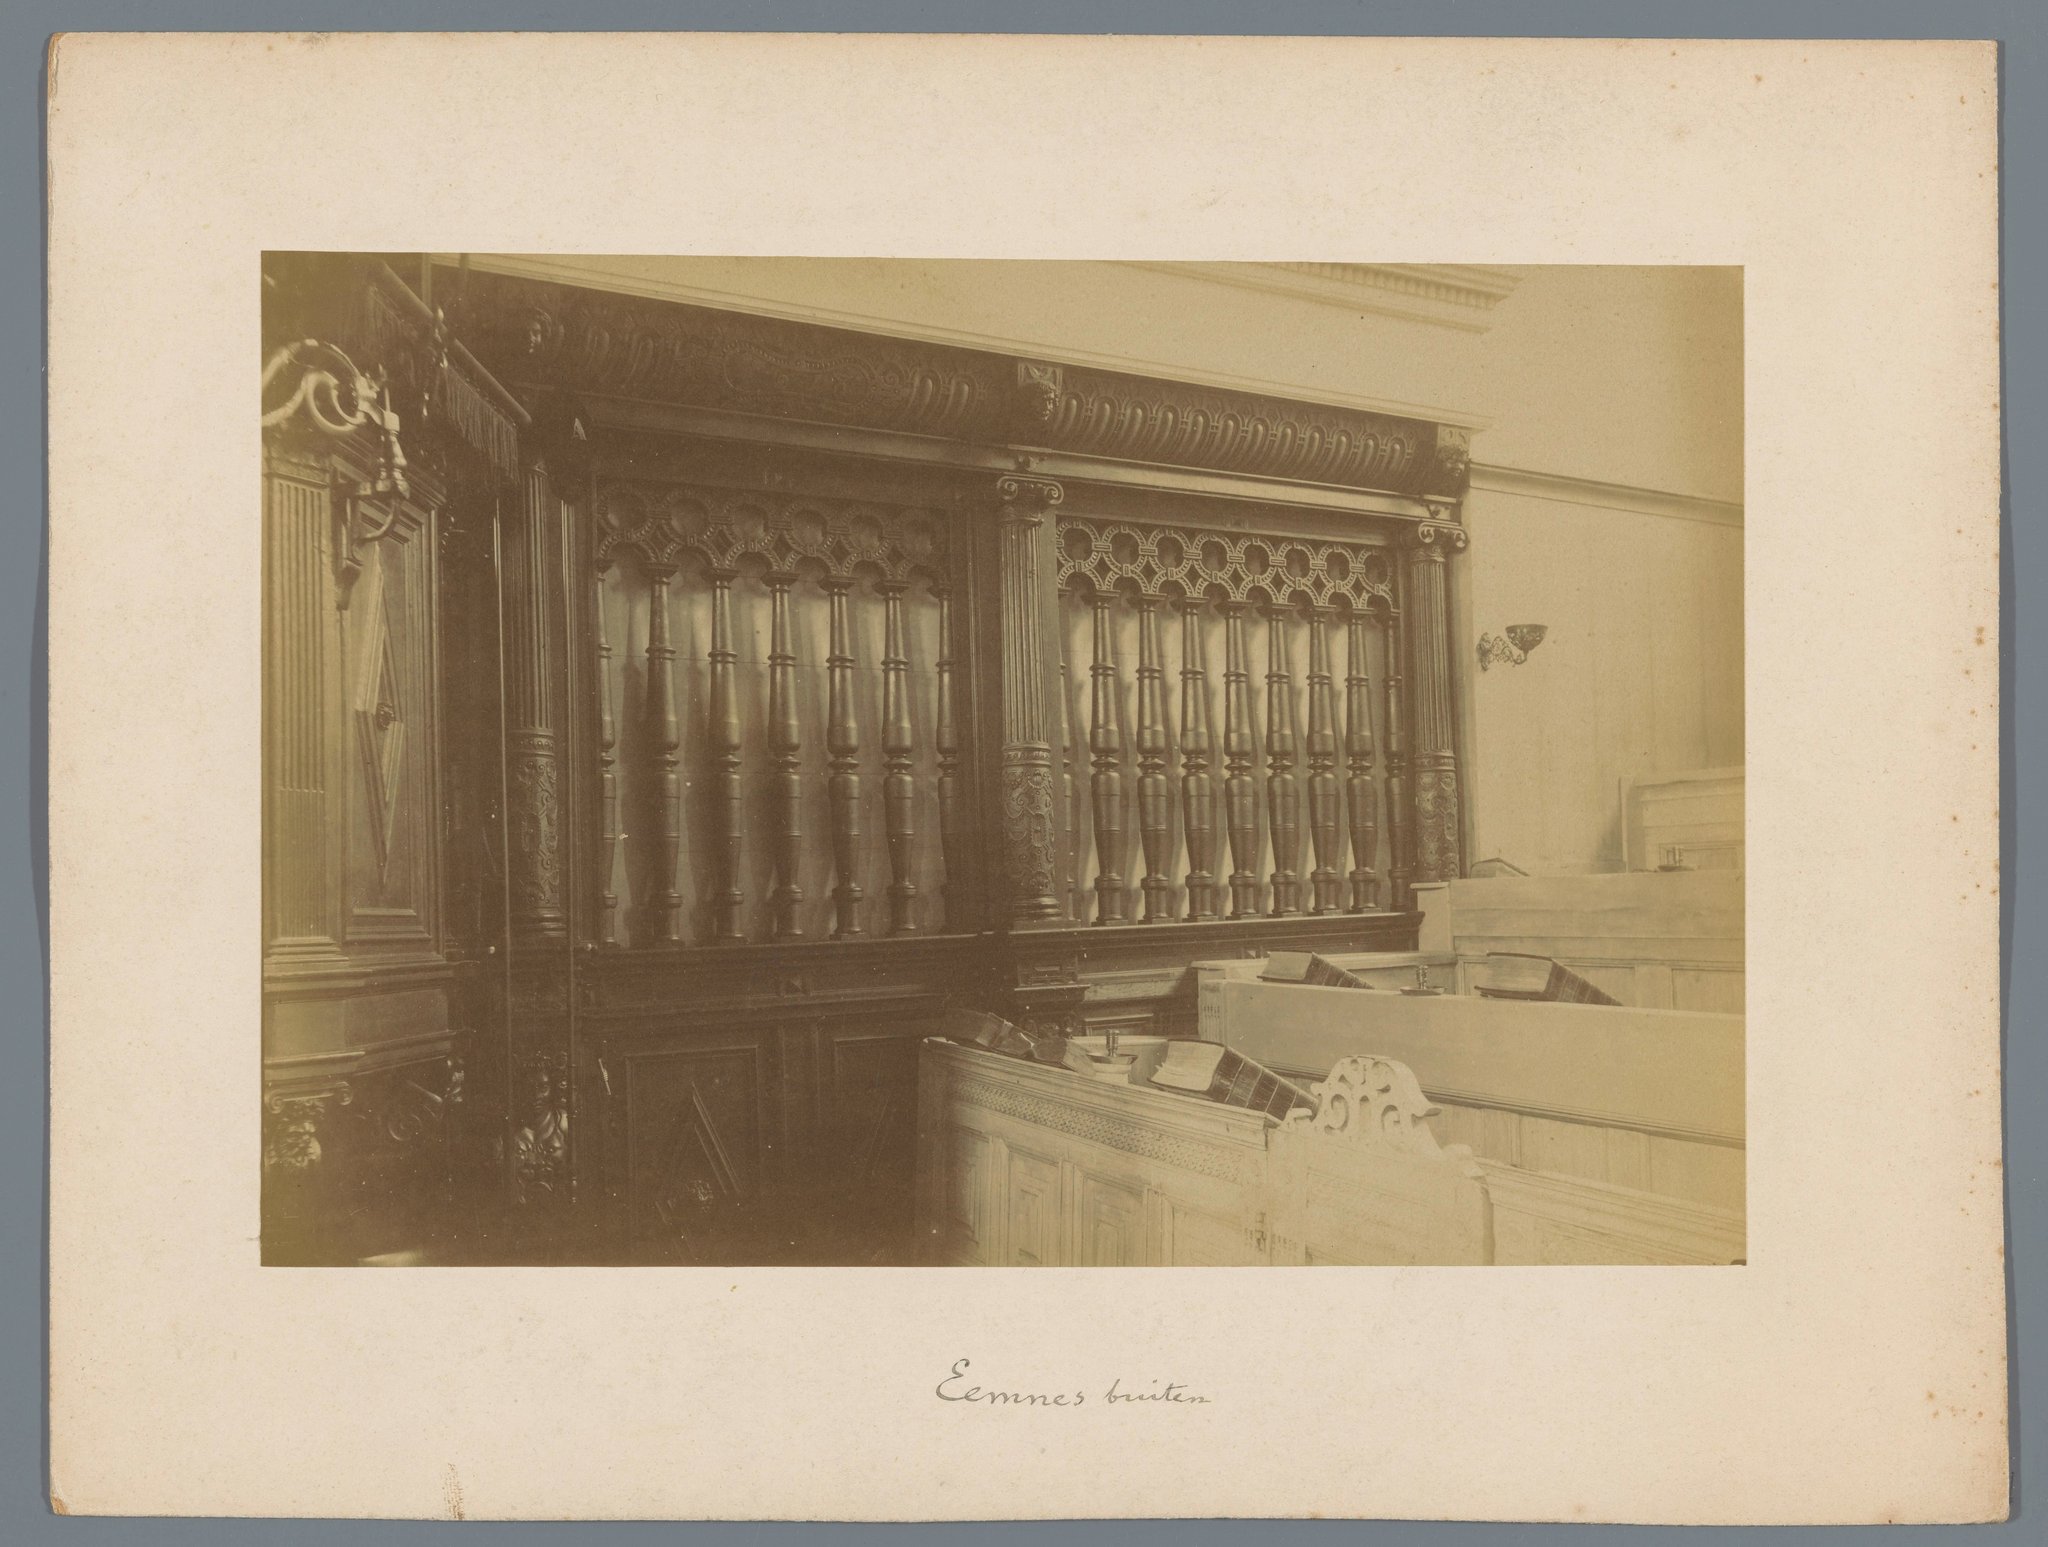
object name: photograph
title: Koorhek in de Nederlands Hervormde kerk te Eemnes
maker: Anonymous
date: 1900-1909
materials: cardboard, photographic support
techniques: albumen print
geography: eemnes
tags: rood-screen, choir-screen; iconostasis, interior of church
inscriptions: annotation, inscription: ‘Eemnes-buiten. U. Ned. Herv. Kerk Choorhek. sept. 1900’, inscription: ‘Eemnes buiten’, inscription: ‘neg. 4099 foto 8334’